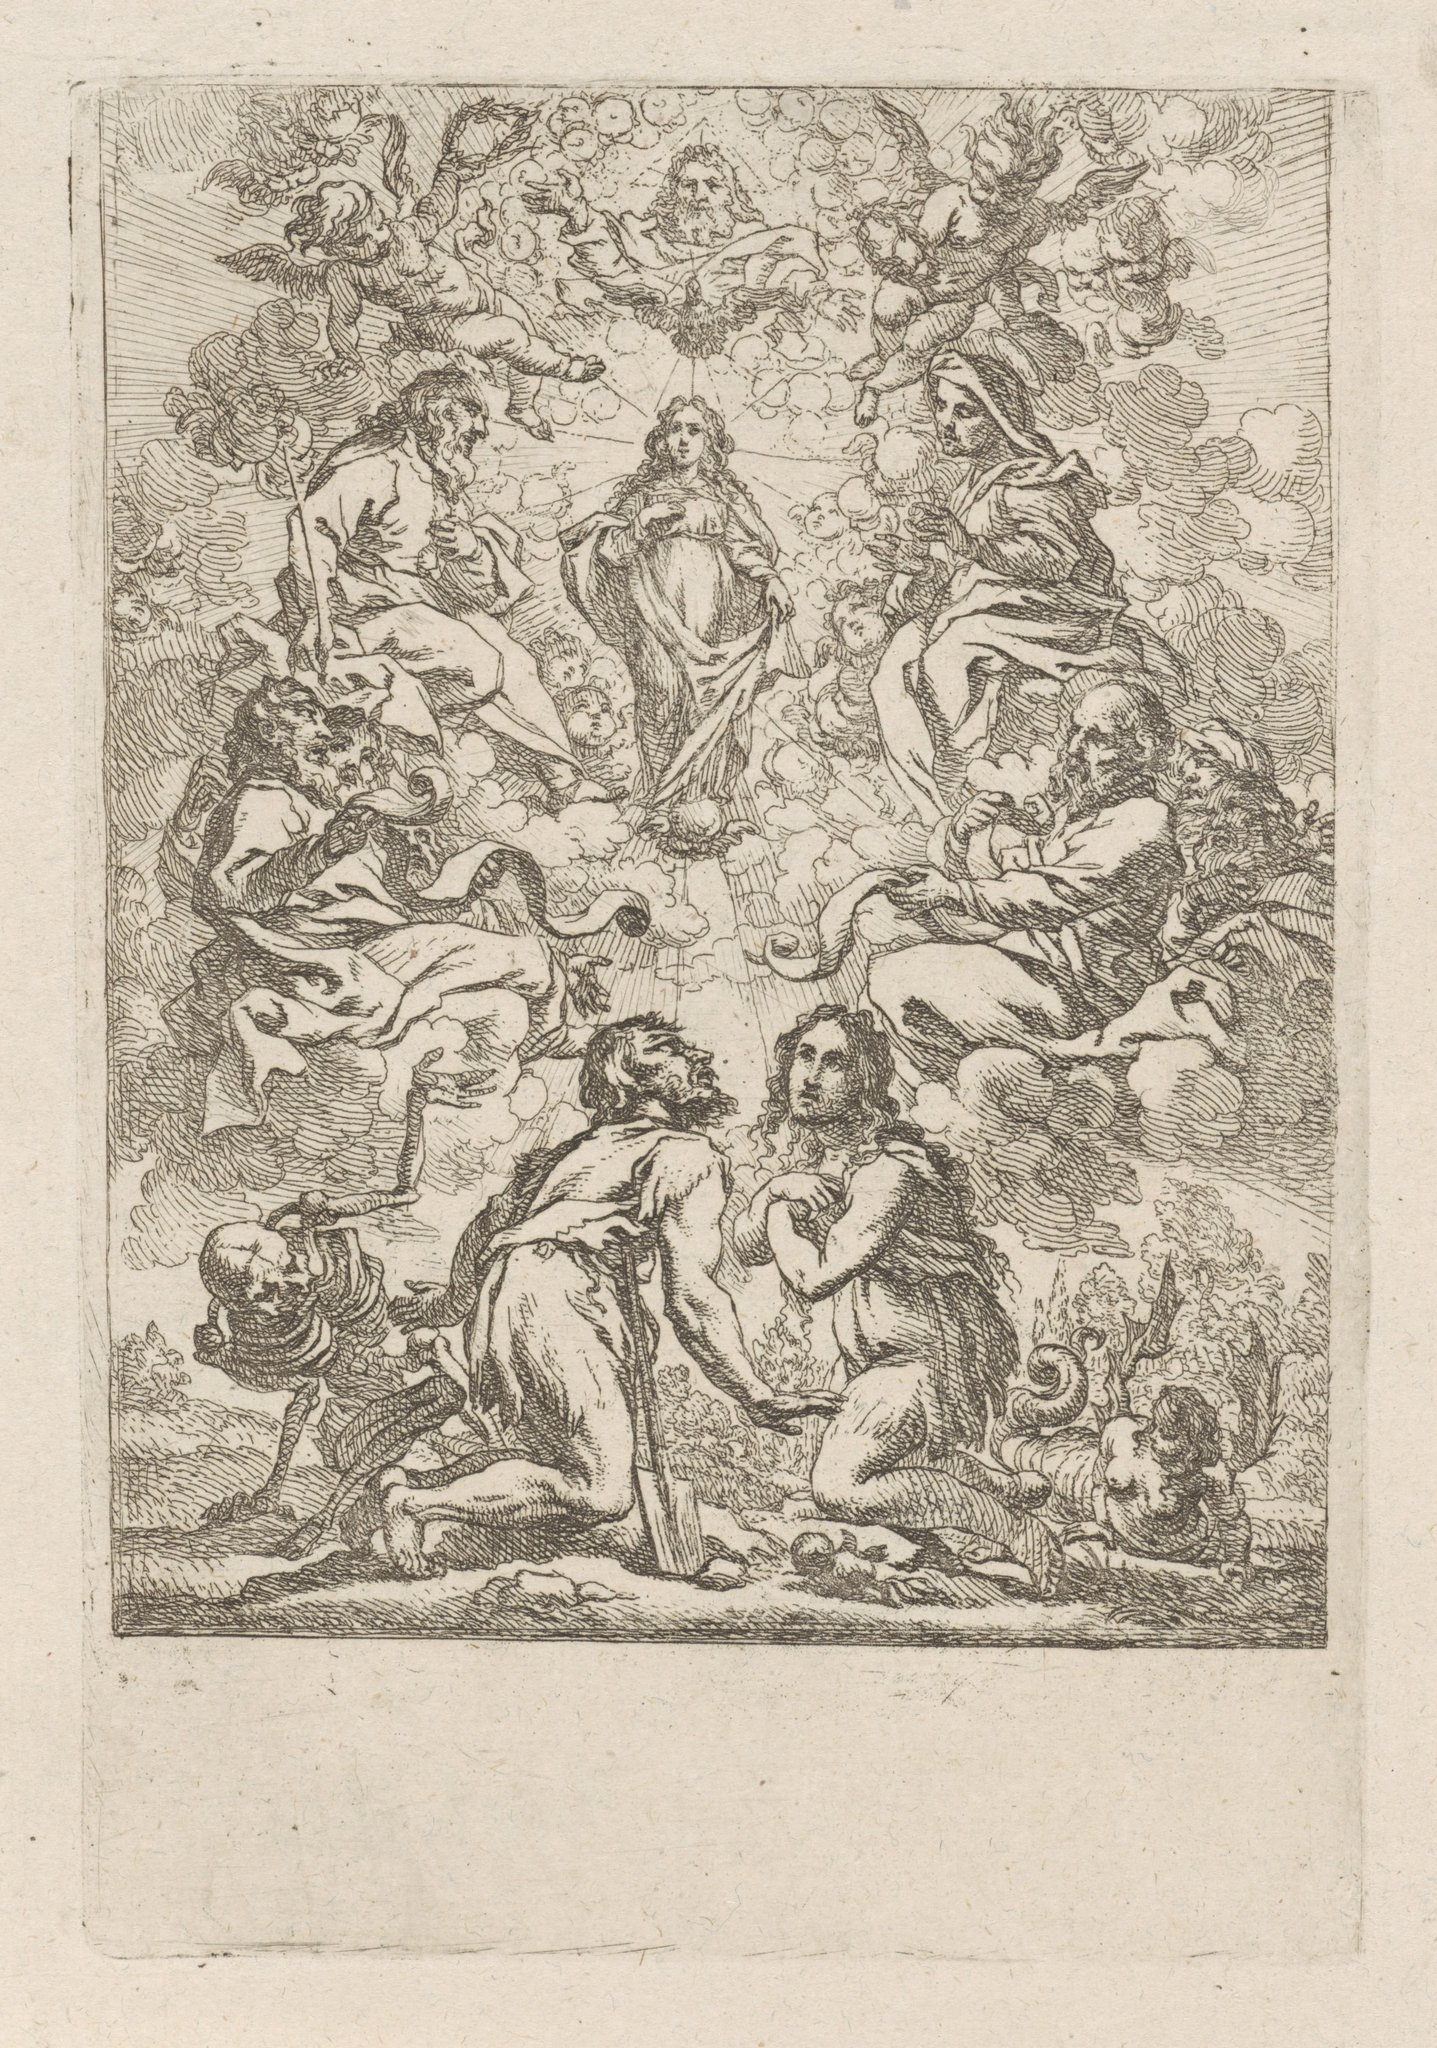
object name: print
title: Adam en Eva knielen voor Maria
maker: cornelis schut (i)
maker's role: draughtsman, print maker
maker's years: 1597-1655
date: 1618-1655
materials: paper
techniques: etching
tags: adam and eve (not in biblical context) - personal devotions of male persons from the old testament, e.g. vision, prayer, penitence, madonna accompanied by saint(s), god the father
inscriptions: collector's mark: Lugt 2228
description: Adam, met naast hem de Dood, en Eva, met achter haar de gevleugelde slang, knielen voor Maria in de wolken. Maria wordt omgeven door de gemeenschap van heiligen en door putti. Bovenaan God de Vader die zijn handen zegenend spreidt en de Heilige Geest.